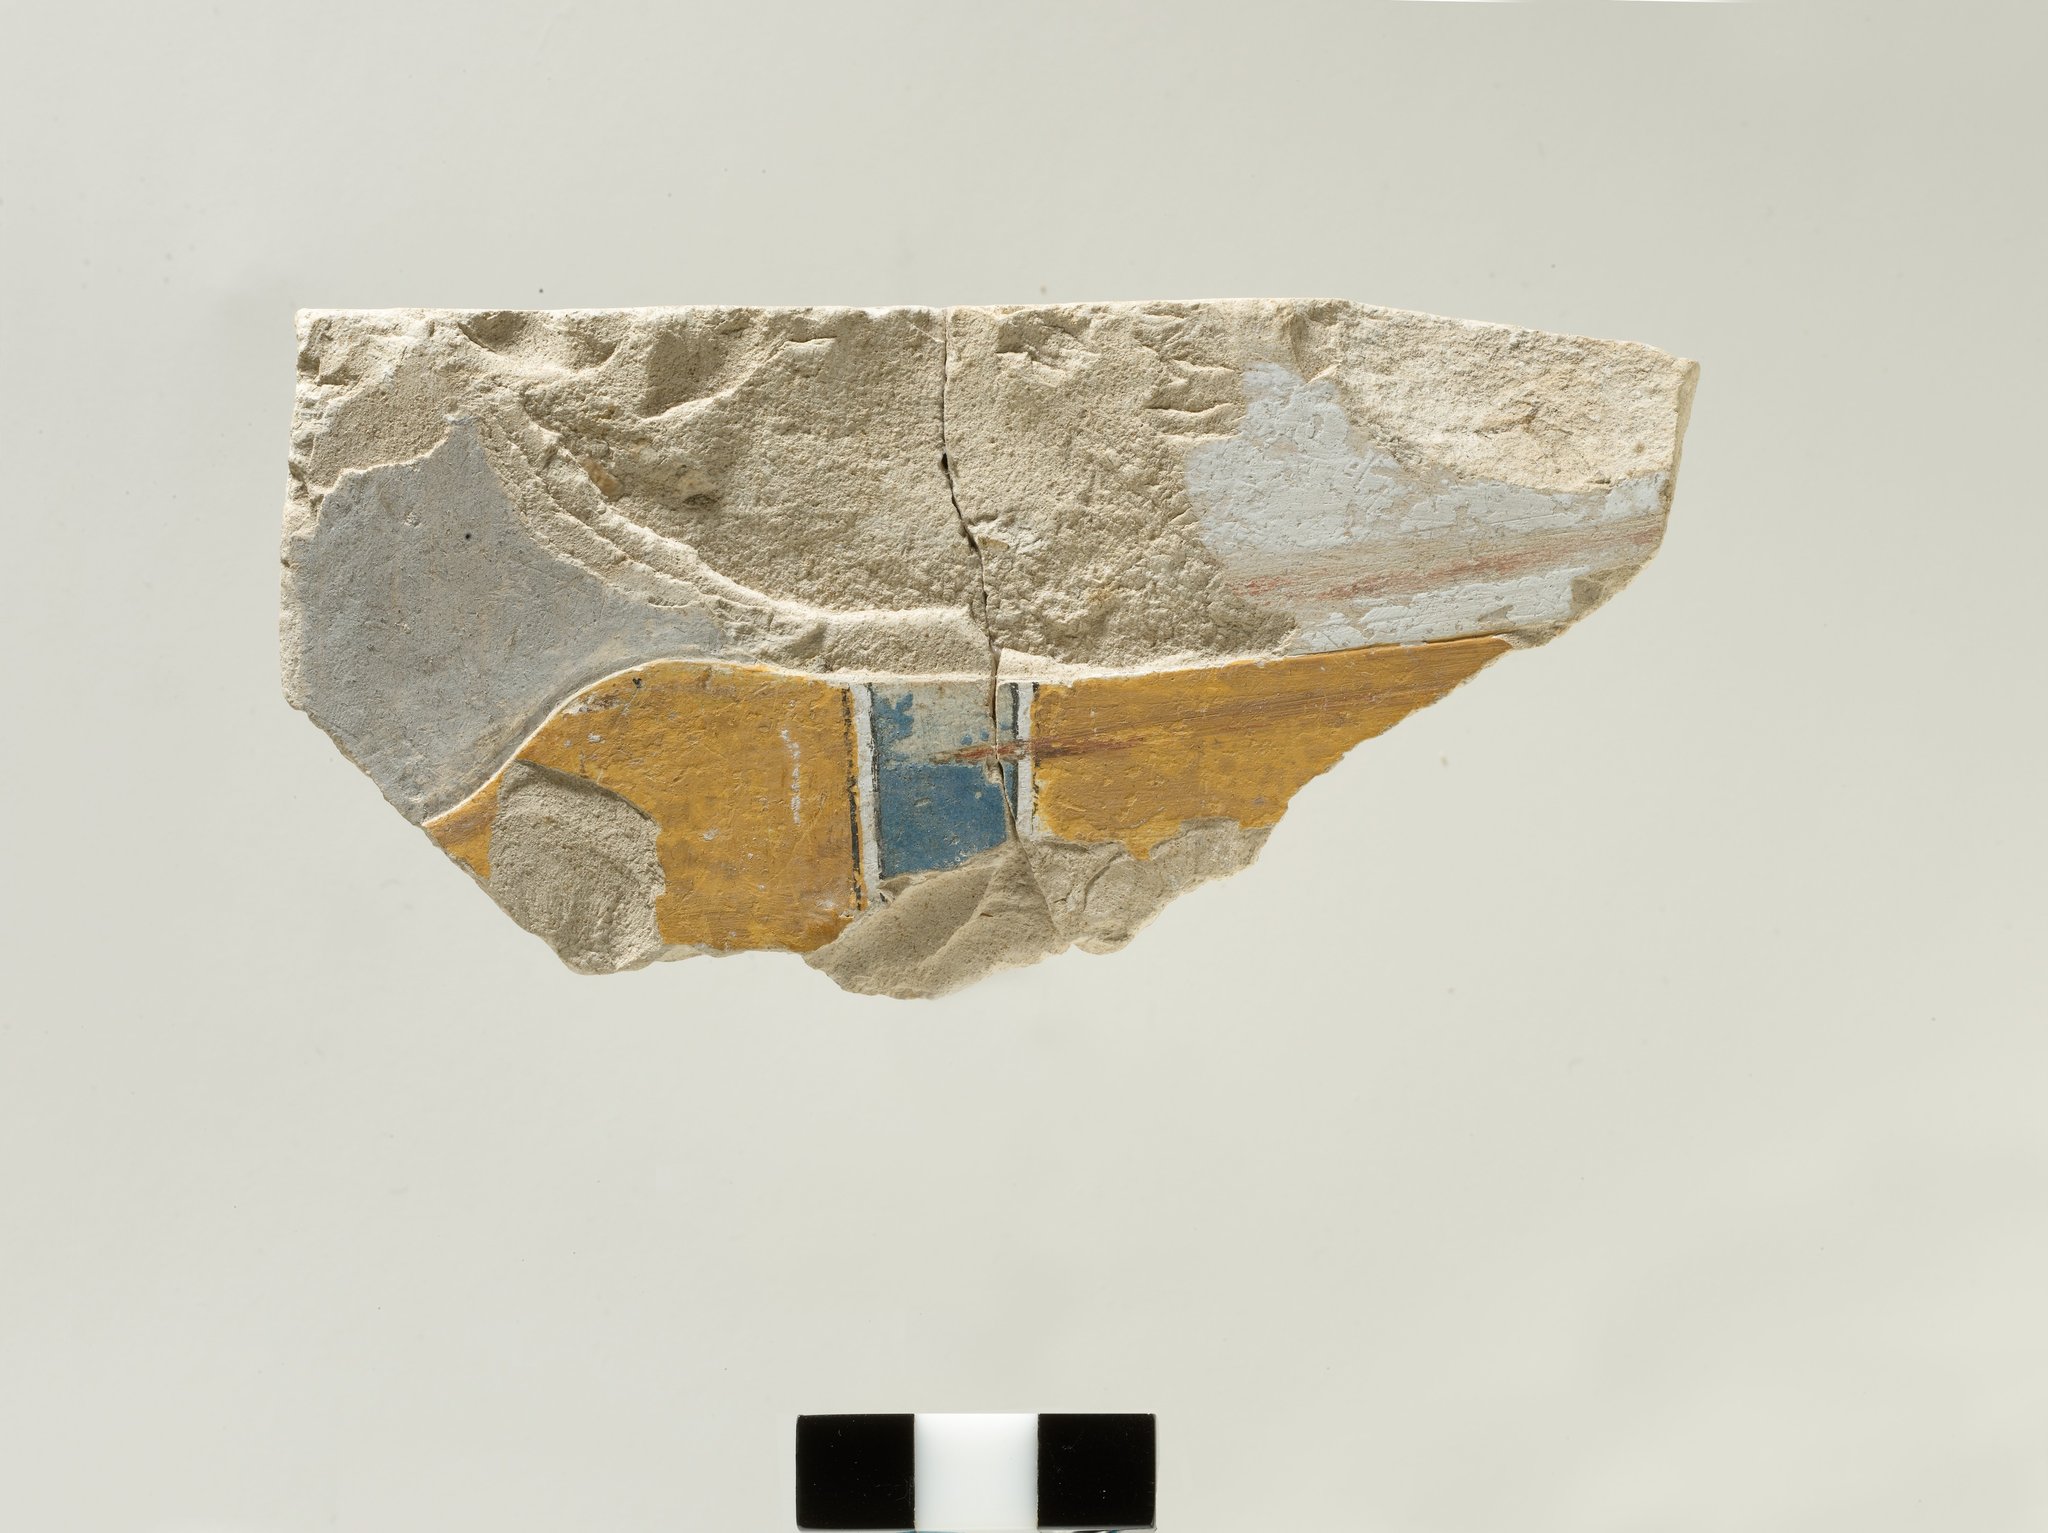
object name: relief fragment, tomb of meketre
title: Reliefs from the tomb of Meketre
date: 1981-1975 BCE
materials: limestone, paint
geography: egypt